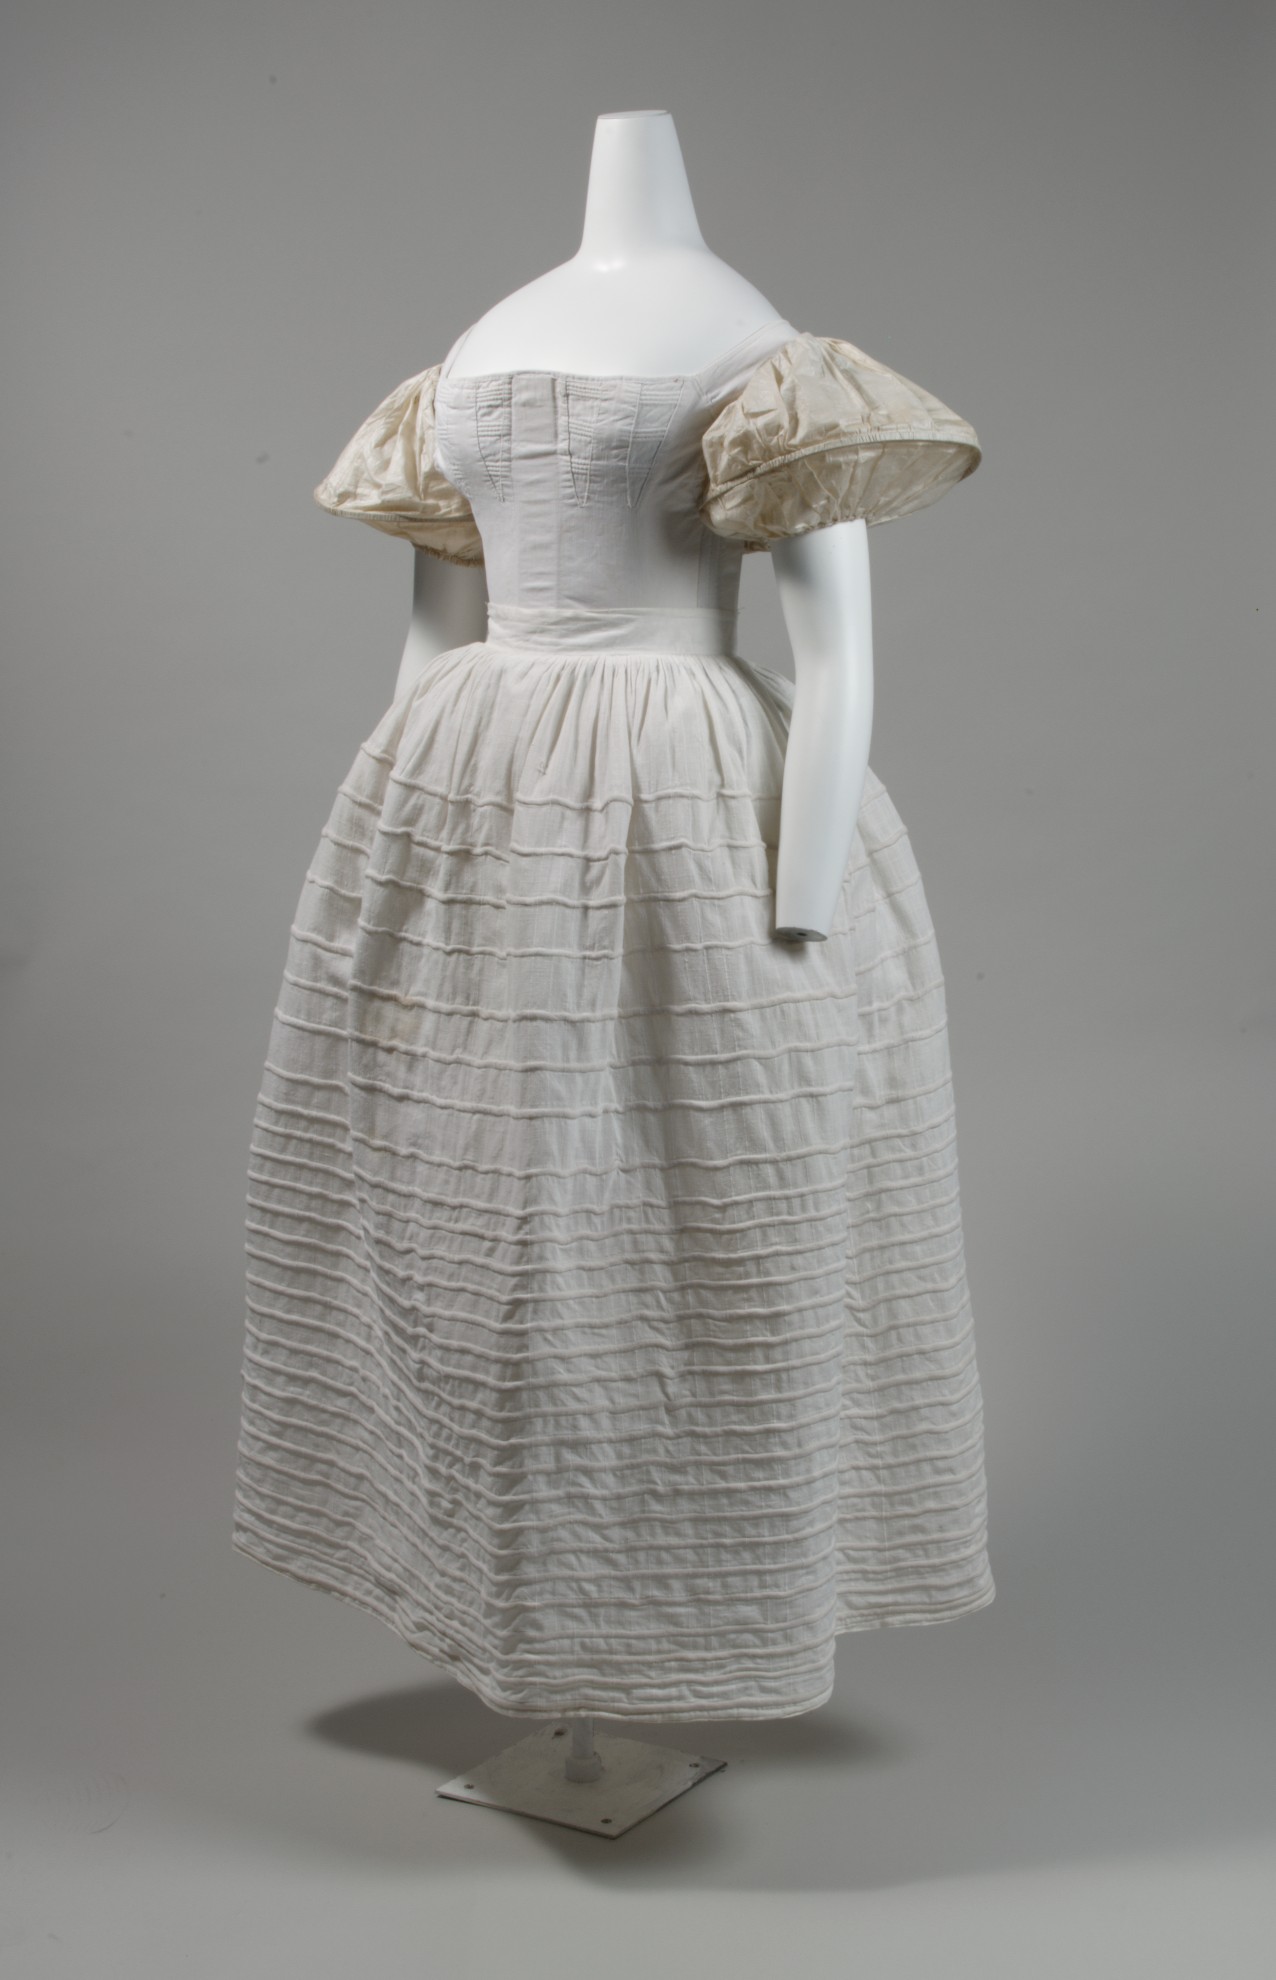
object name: sleeve support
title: Sleeve supports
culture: british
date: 1828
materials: cotton